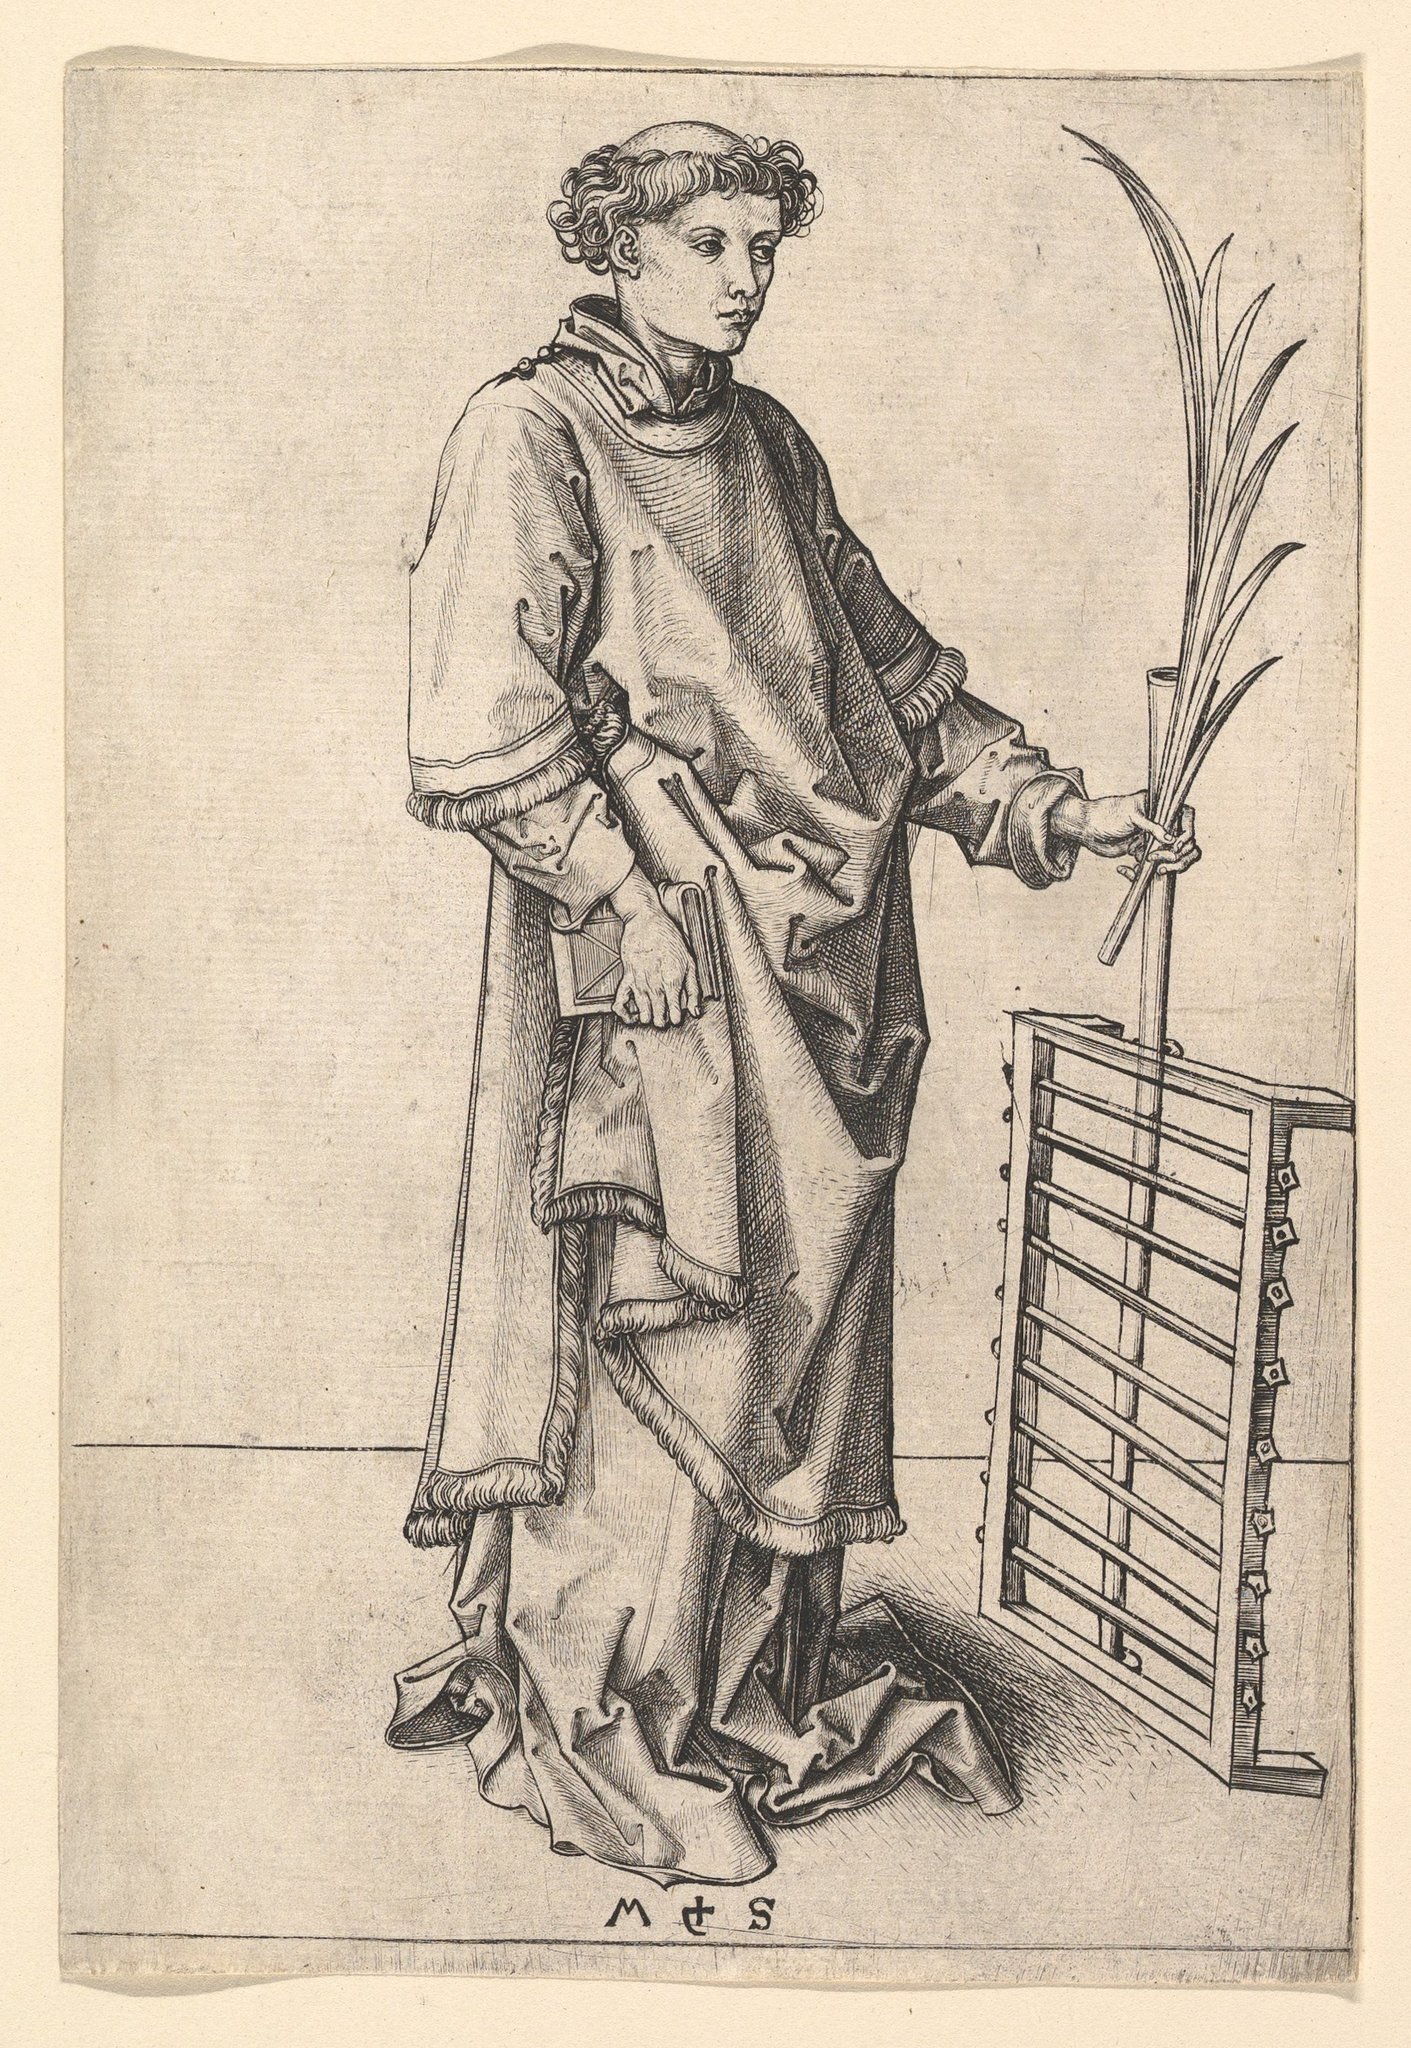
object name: print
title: Saint Lawrence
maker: martin schongauer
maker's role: artist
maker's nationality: german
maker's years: 1430-1491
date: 1470-1491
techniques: engraving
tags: saint lawrence